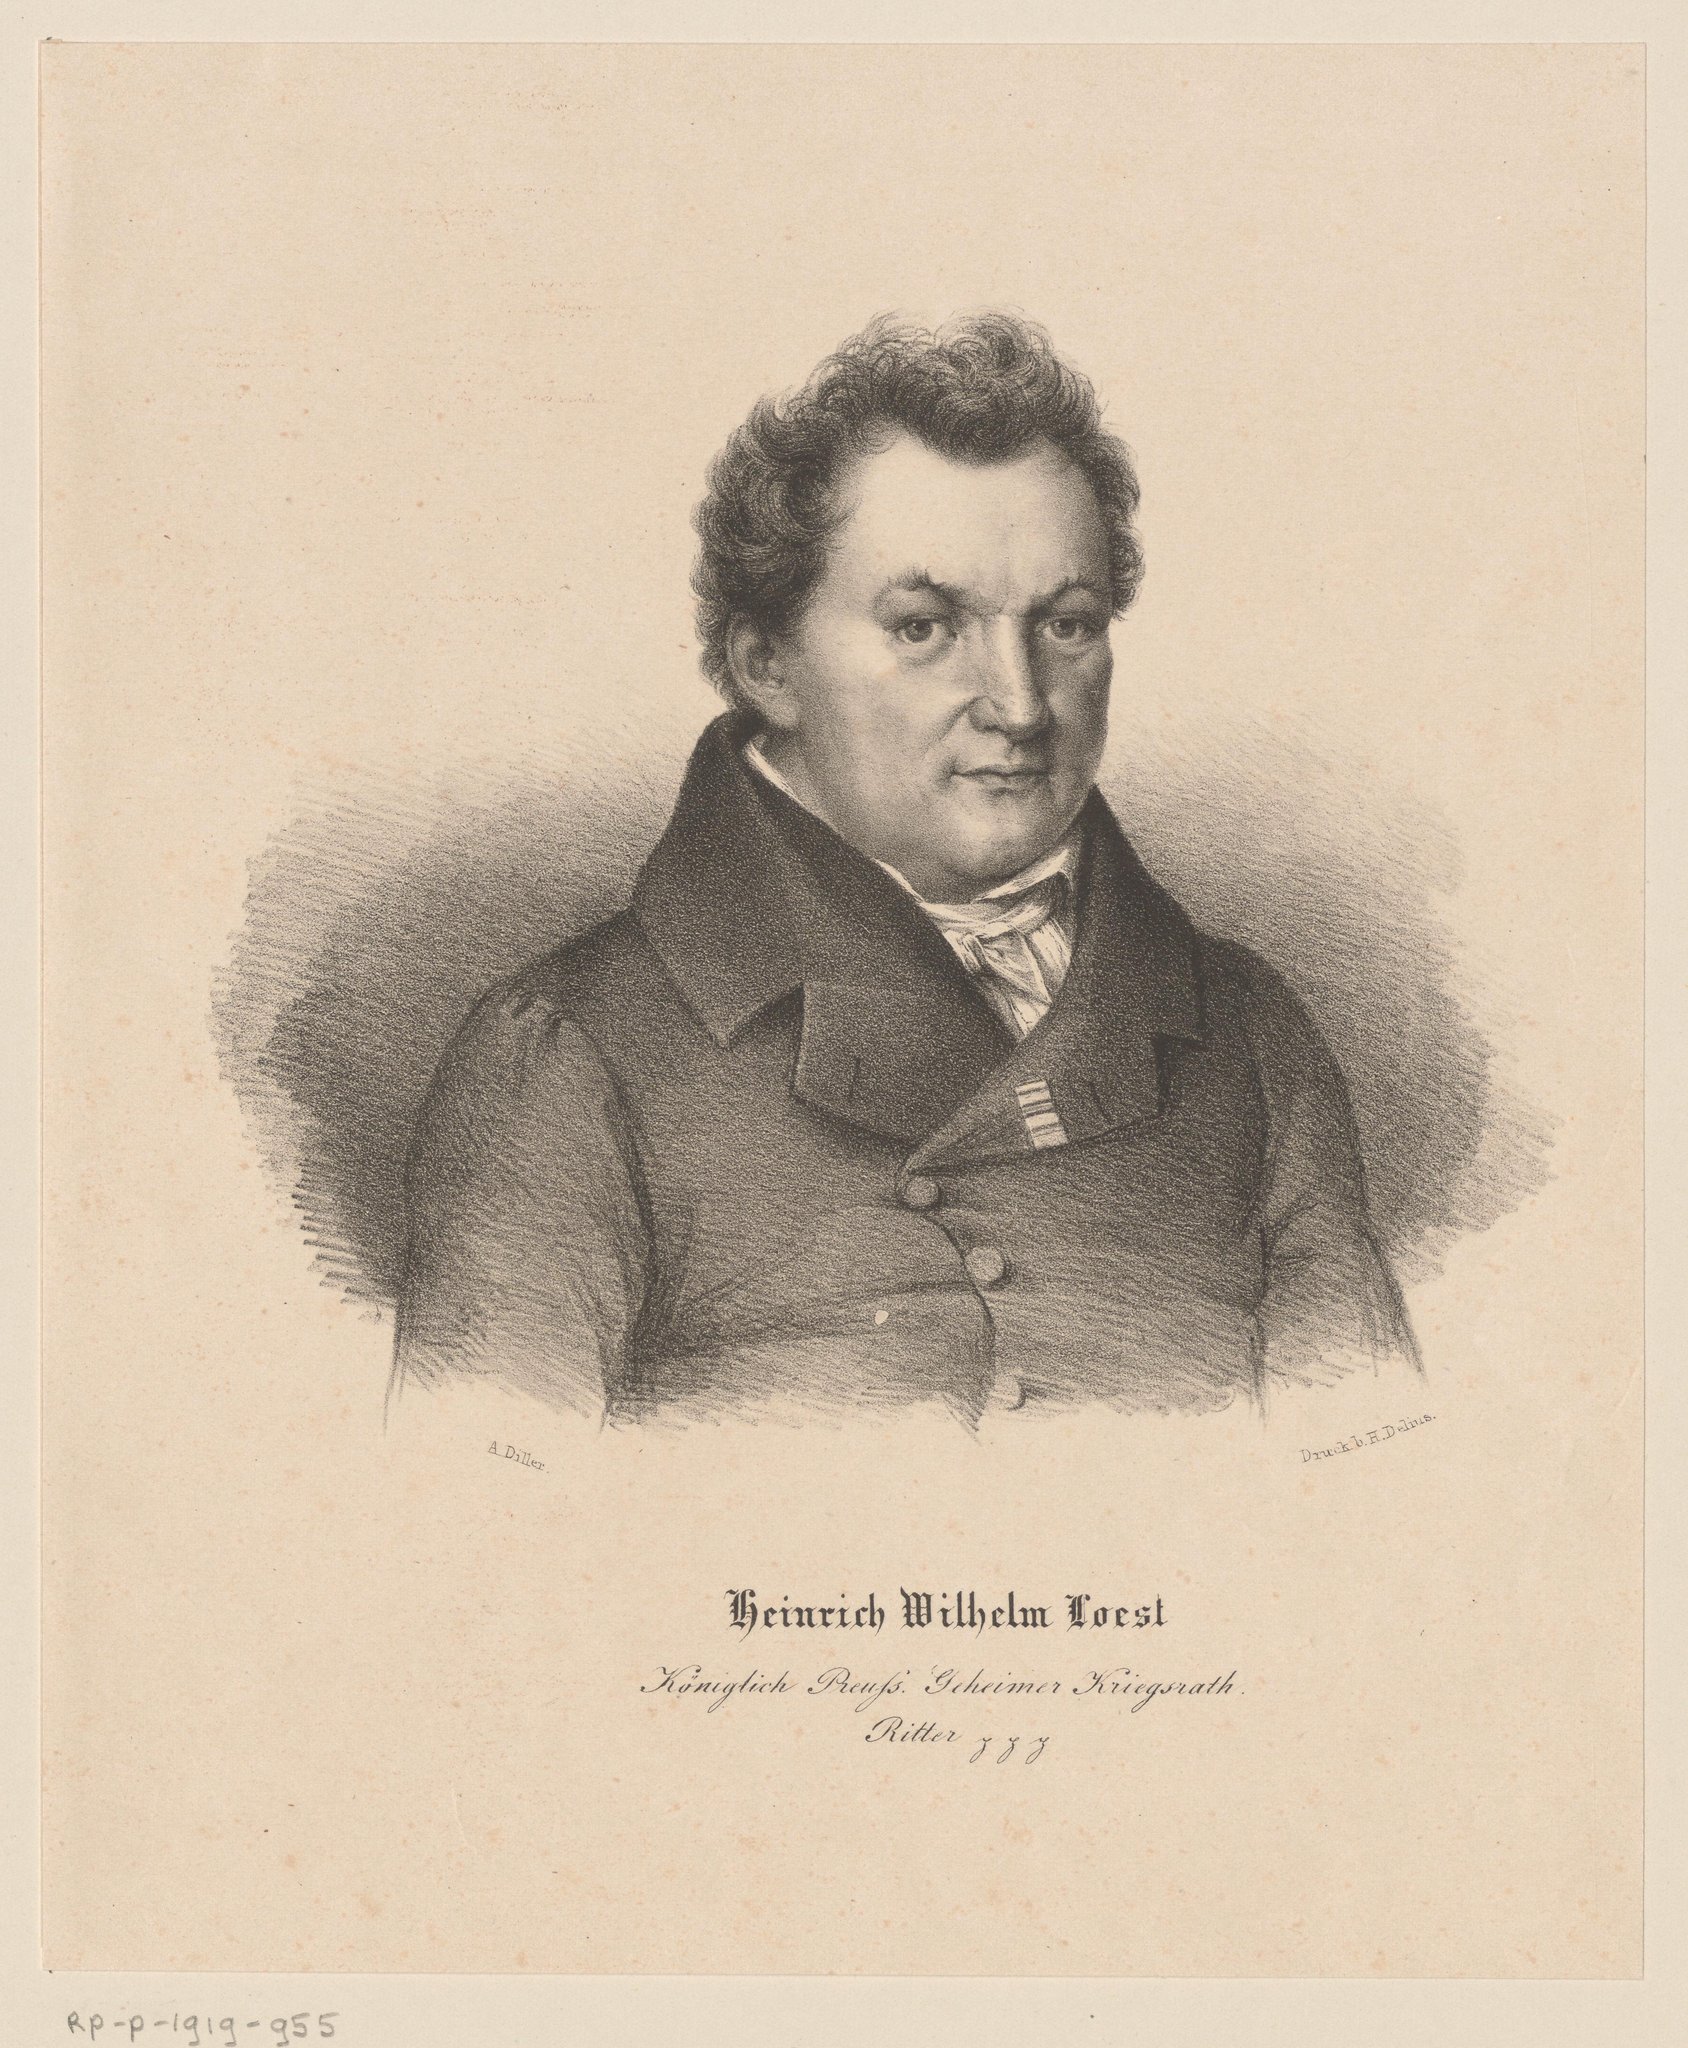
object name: print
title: Portret van Heinrich Wilhelm Loest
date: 1842-1848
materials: paper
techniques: lithograph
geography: germany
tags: historical persons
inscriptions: collector's mark: Lugt 2228